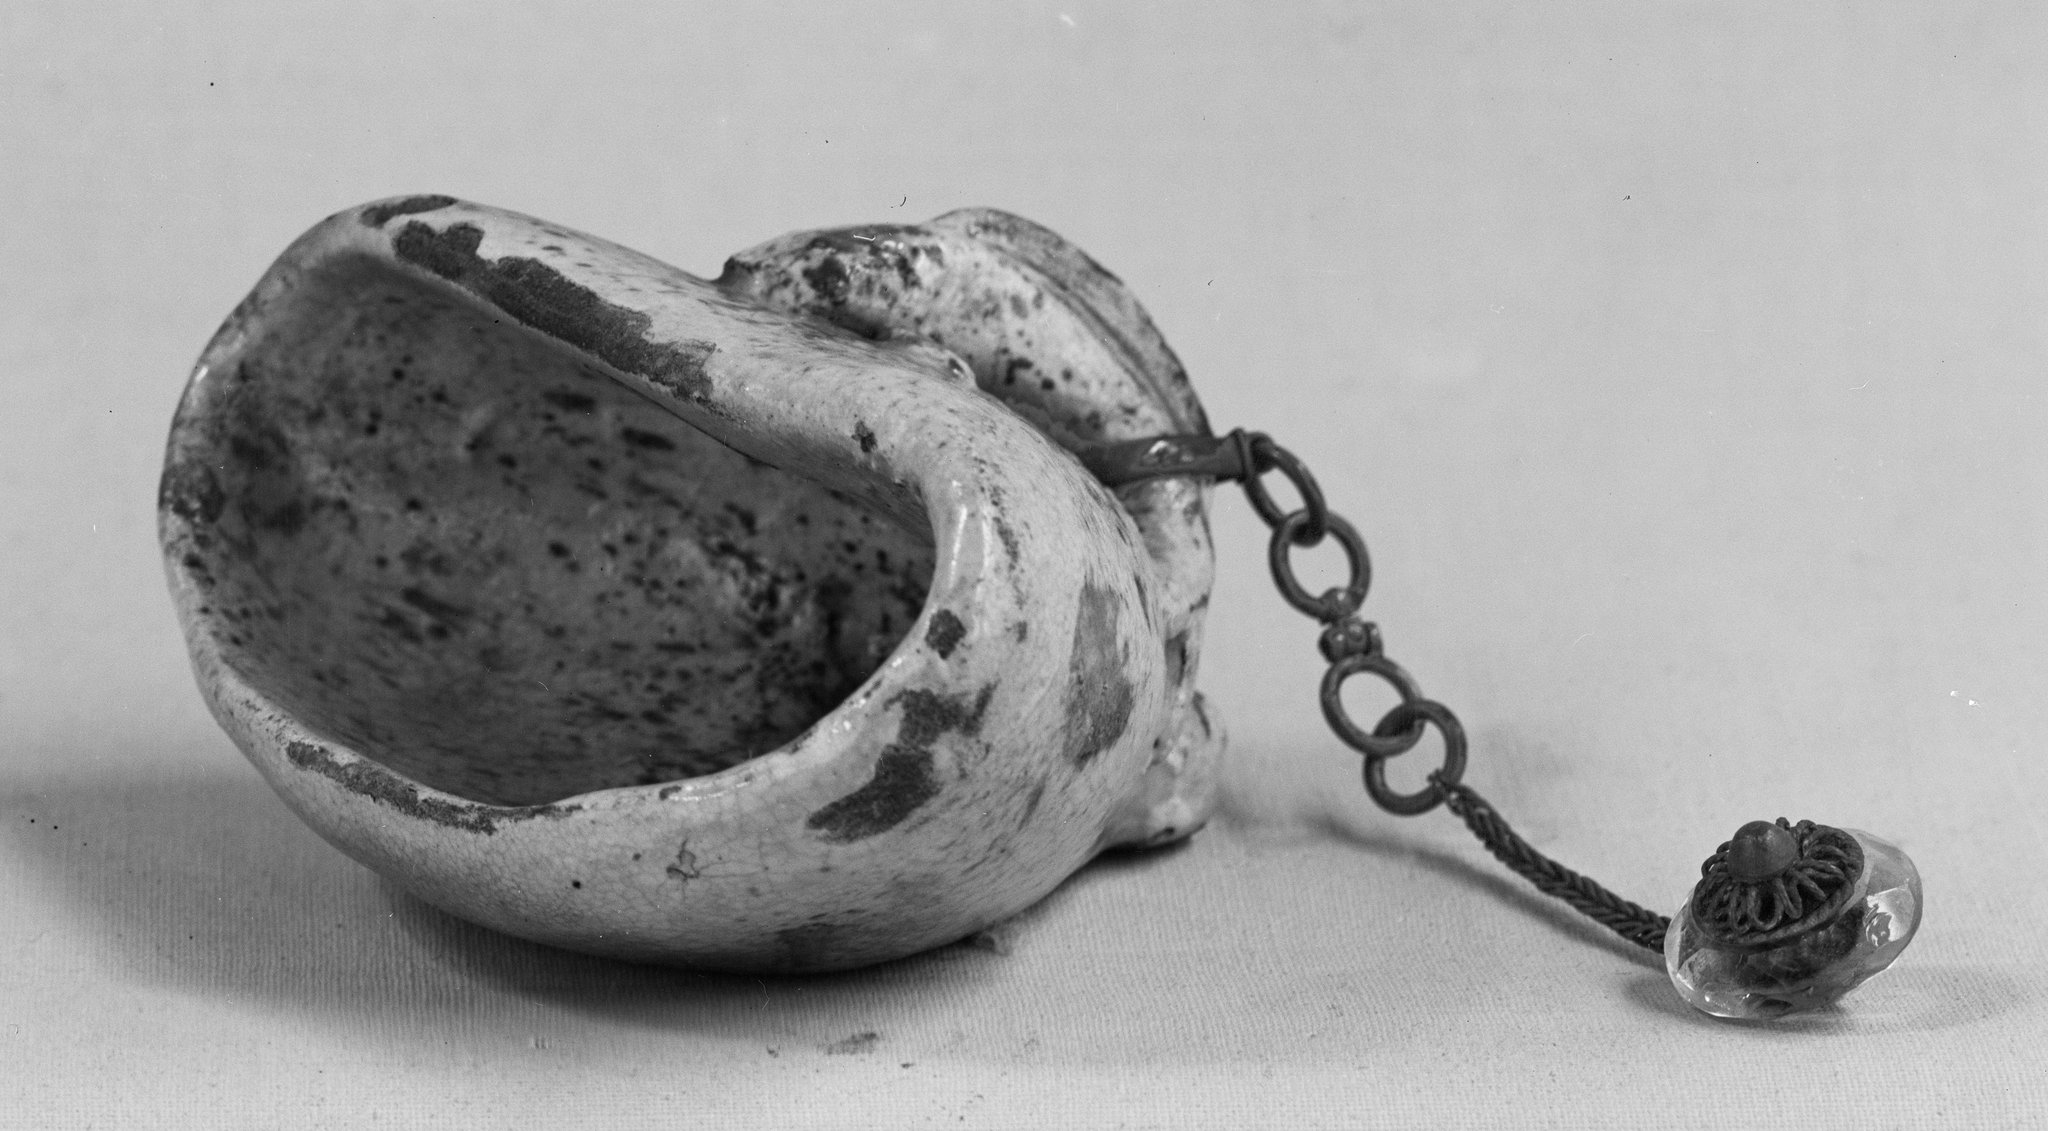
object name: pilgrim's cup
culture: japanese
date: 1701-1800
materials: glass, glaze, pottery, silver